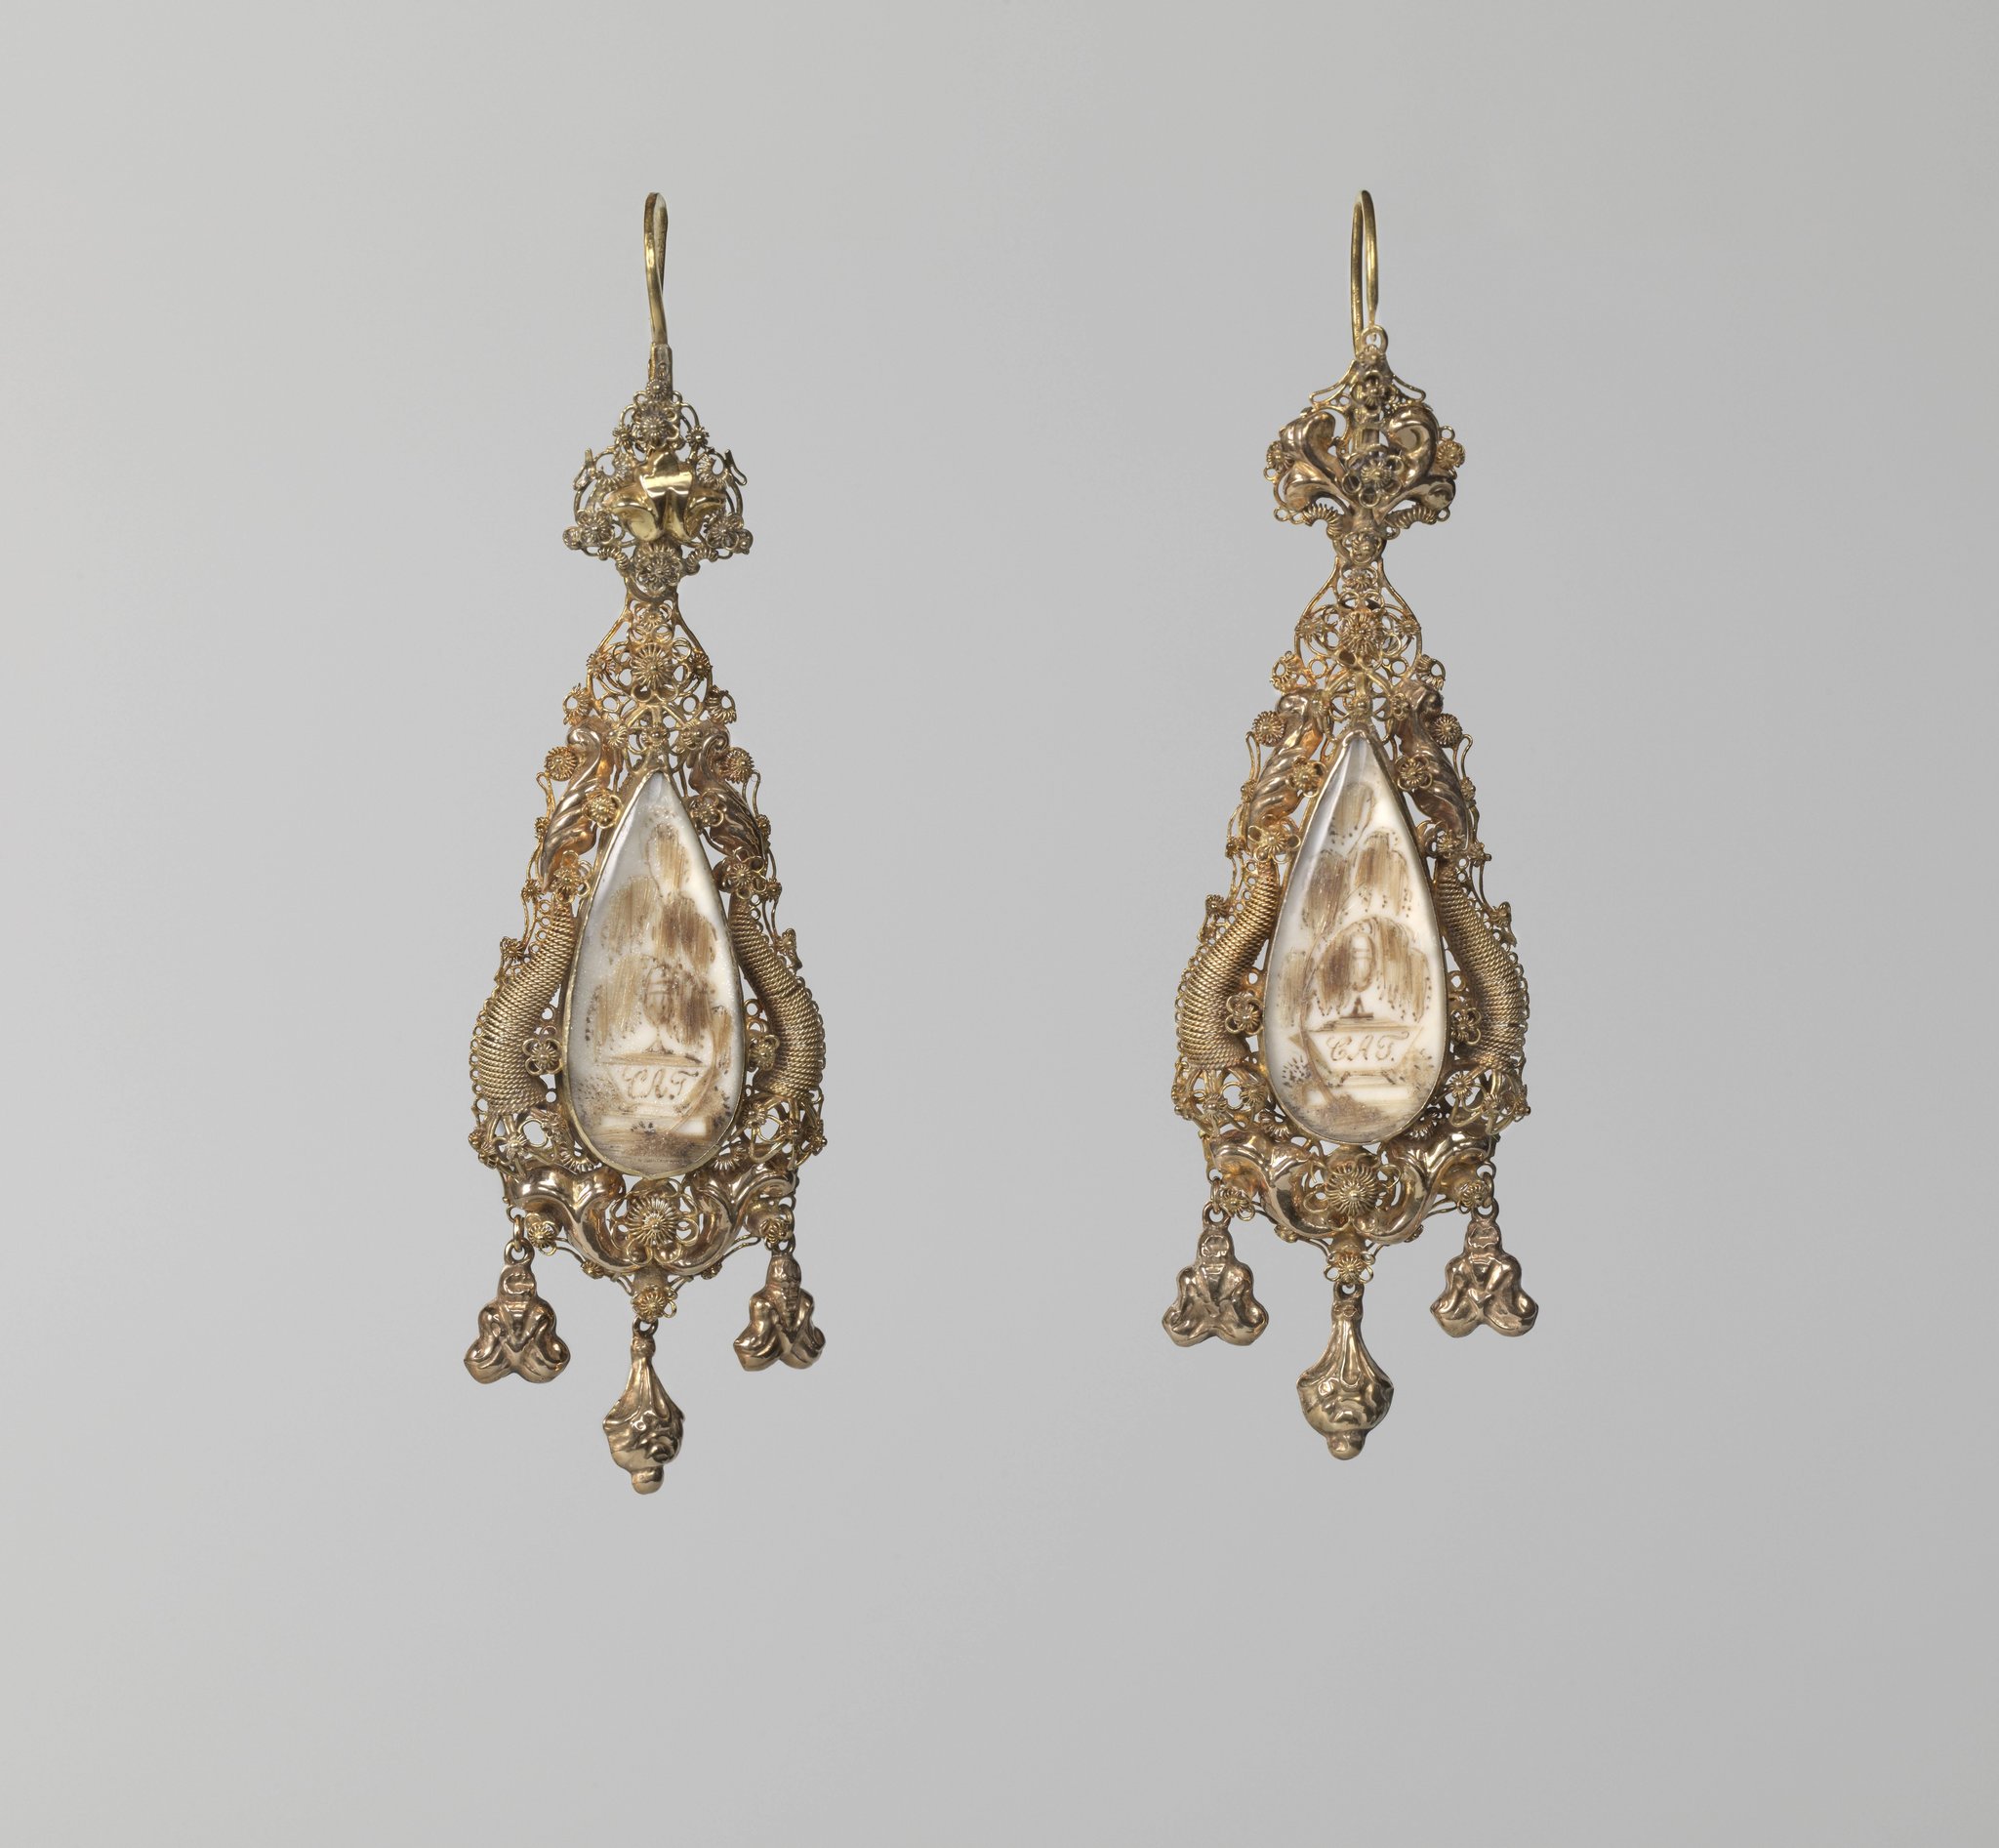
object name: ear ornament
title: Oorhanger met haarwerk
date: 1841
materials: glass, gold, hair, ivory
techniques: filigree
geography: amsterdam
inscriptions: alloy mark: ‘leeuwenkop naar links (Nederland, 1813-1906)’, maker's mark: ‘FG waartussen een klaverblad in zeshoek’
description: Earrings. Gold, ivory and hair. Amsterdam, 1841, by Frederik Muhlenschmidt and Willem Schammer.